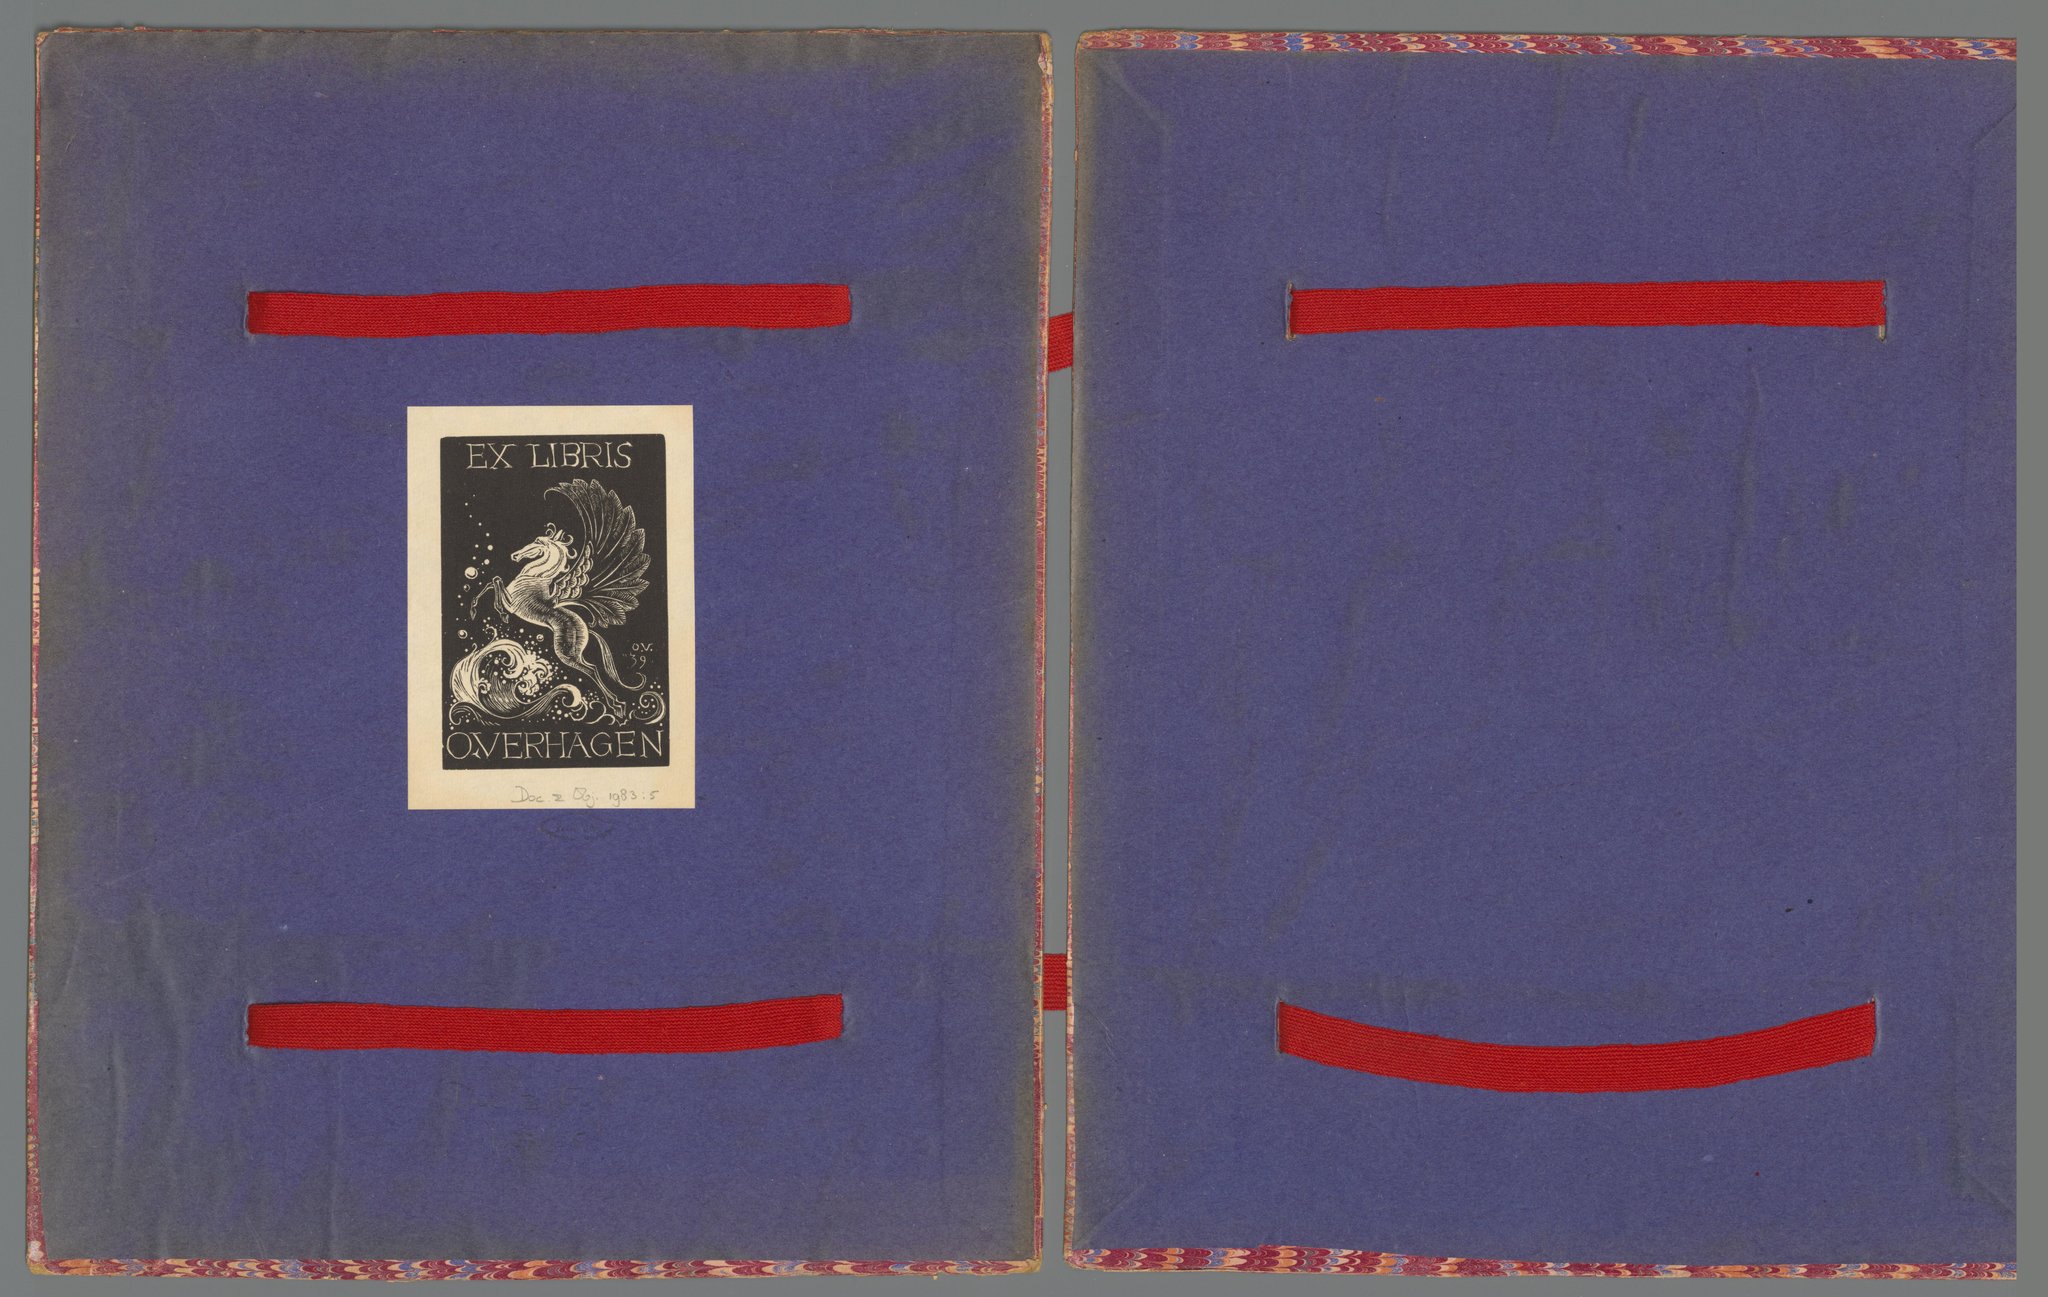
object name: wrapper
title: Omslag met ex libris van Kornél Révész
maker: Anonymous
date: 1900-1949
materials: cardboard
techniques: bookbinding, marbling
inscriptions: collector's mark, bookplate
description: Omslag bevat 64 objecten op 34 losse opzetvellen, een gebonden catalogus van Kornél Révész en een tekstblad.